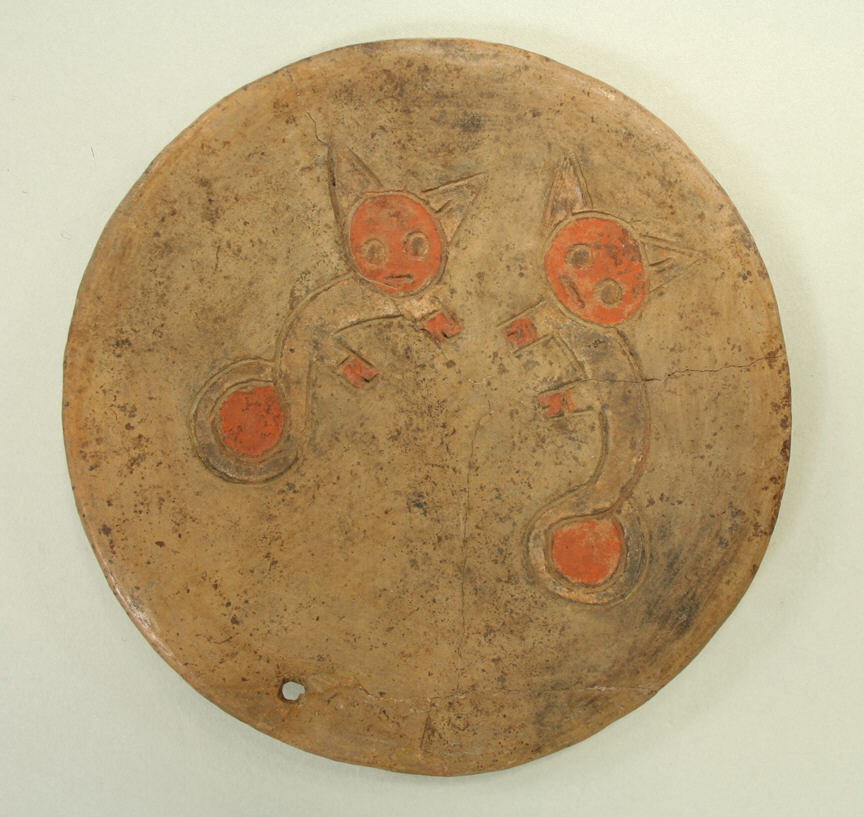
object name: dish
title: Dish Incised with Two Cats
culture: paracas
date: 300-101 BCE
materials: ceramic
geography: peru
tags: cats